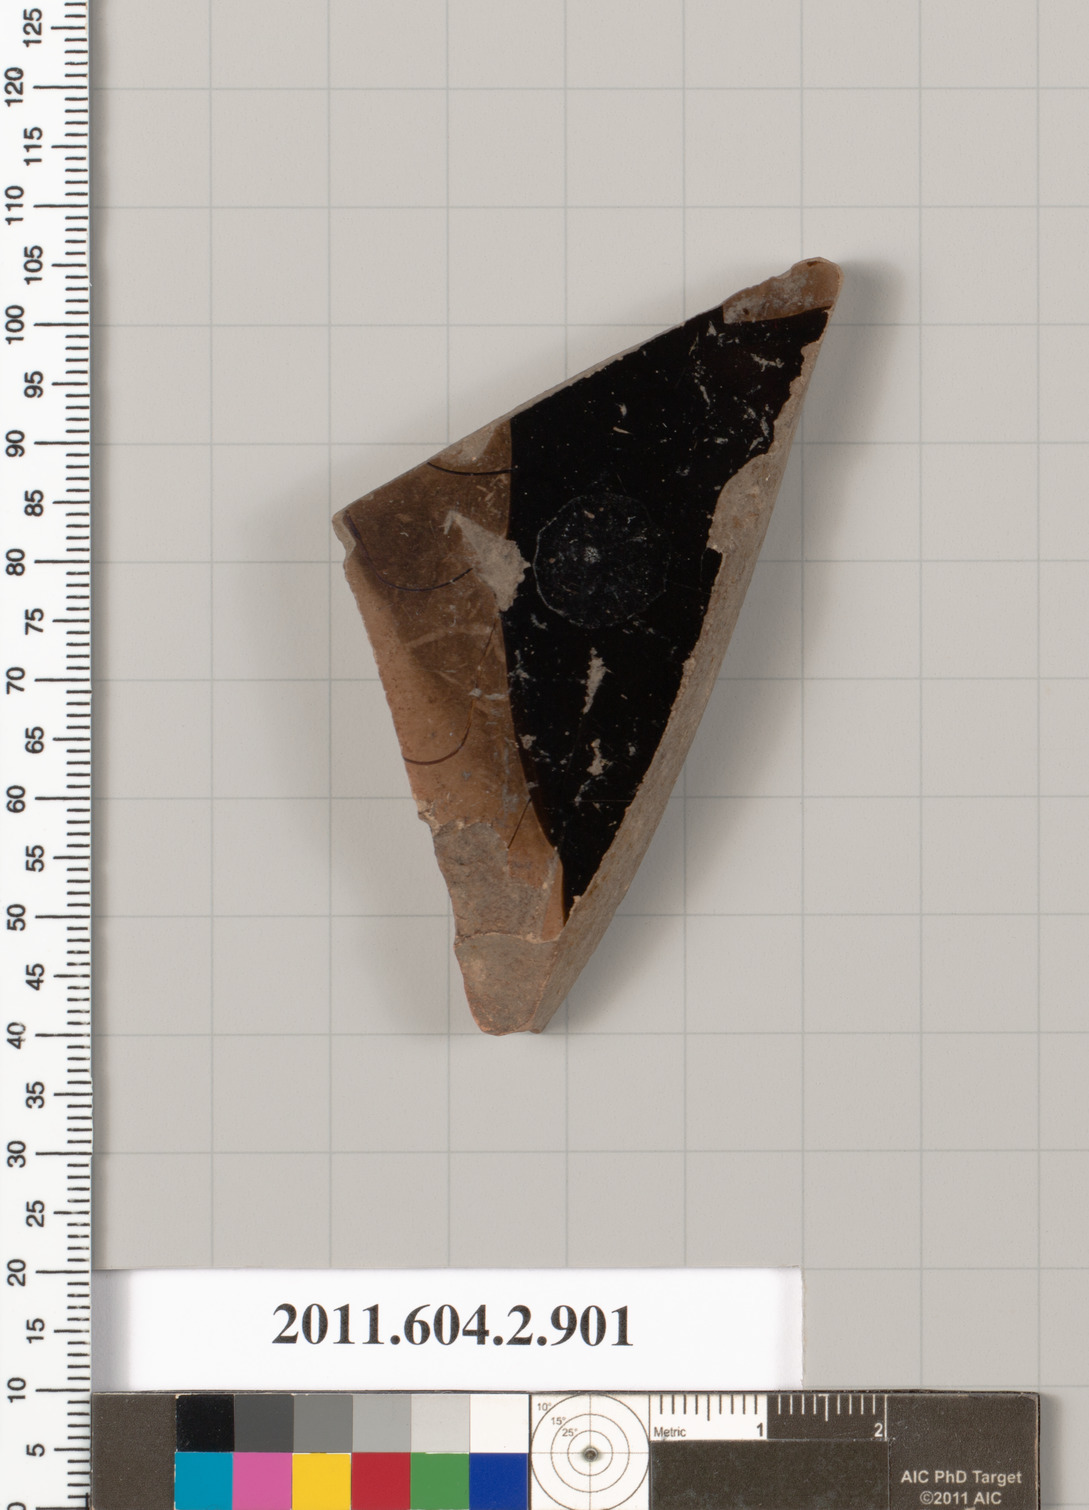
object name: bell krater fragment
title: Terracotta fragment of a bell-krater (bowl for mixing wine and water)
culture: greek, attic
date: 460-440 BCE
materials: terracotta